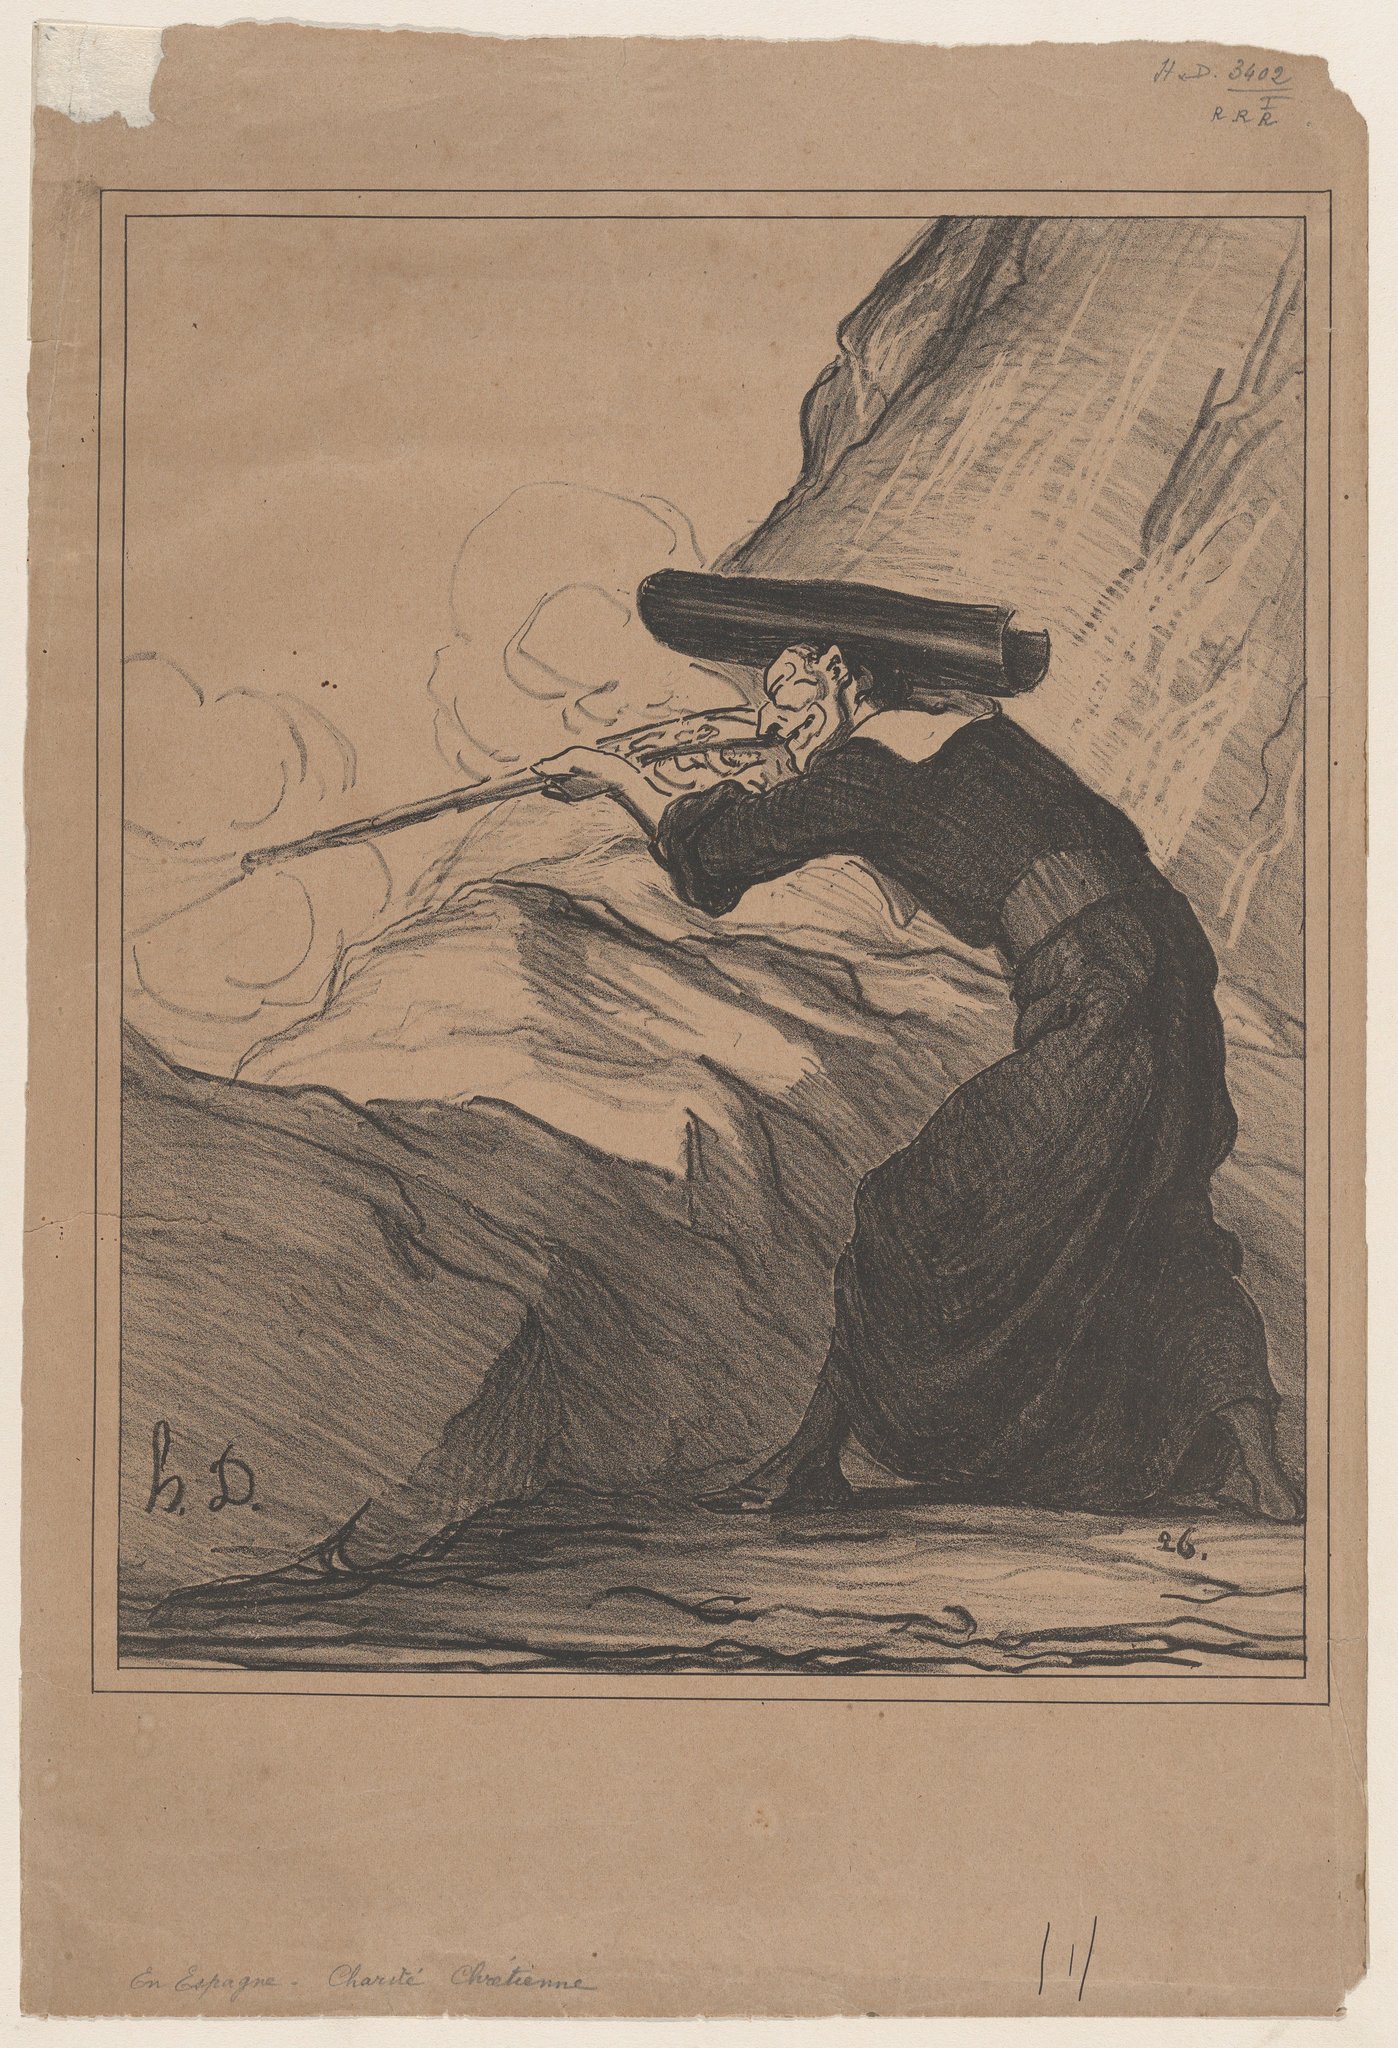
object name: print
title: In Spain - Christian charity, from 'News of the day,' published in Le Charivari, May 29, 1872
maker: honoré daumier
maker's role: artist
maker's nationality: french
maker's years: 1808-1879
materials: paper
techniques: lithograph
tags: firearms,men